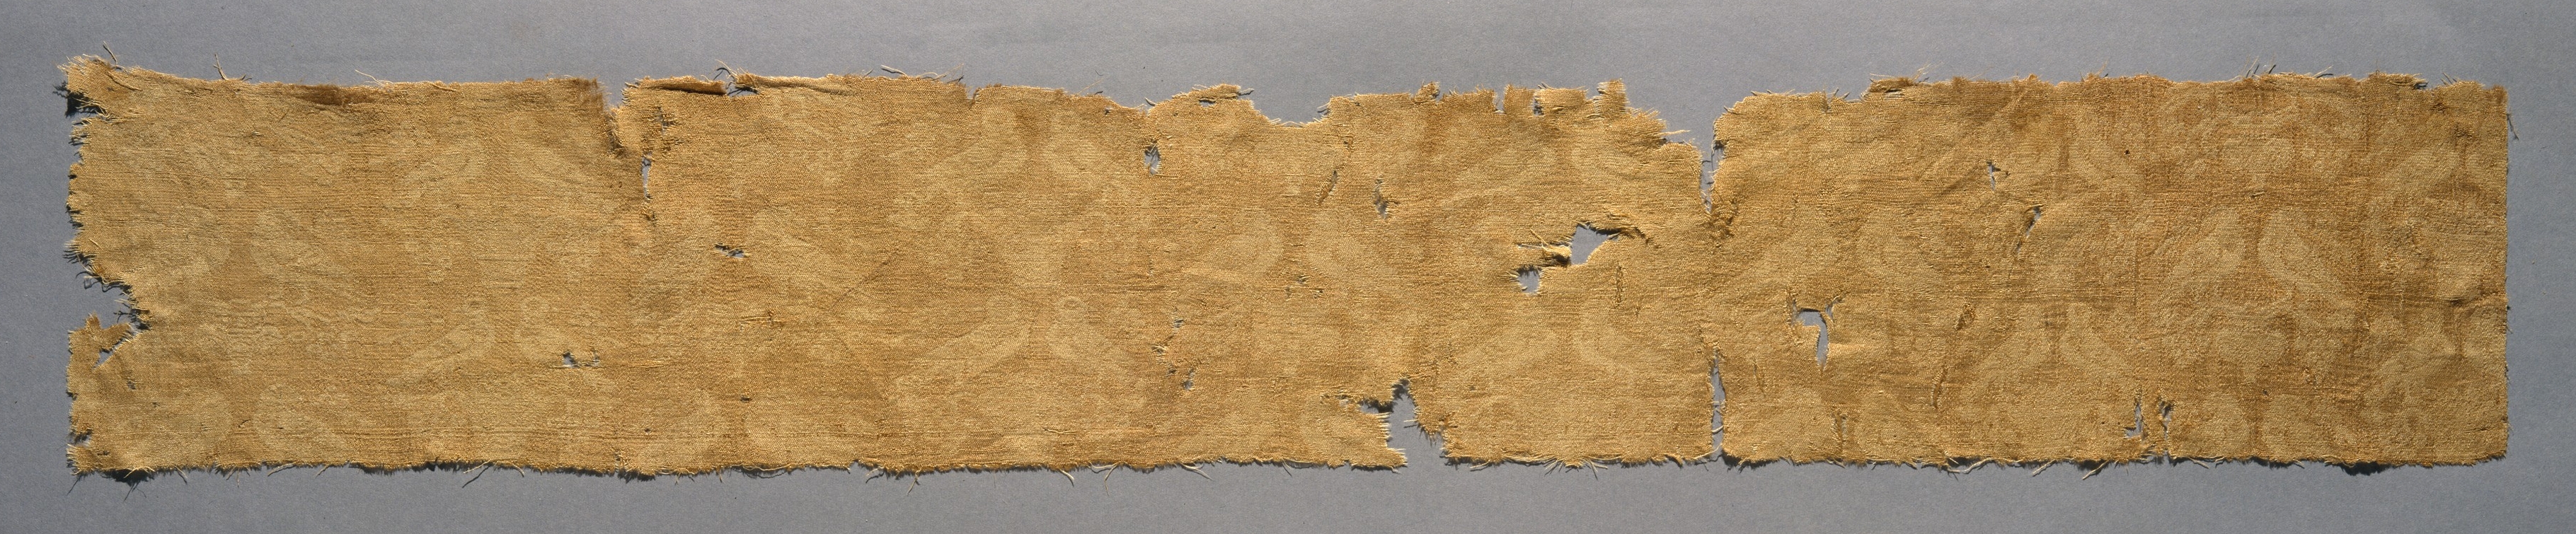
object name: textile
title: Figured woven silk textile fragment with birds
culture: byzantine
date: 401-600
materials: silk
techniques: weave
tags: birds